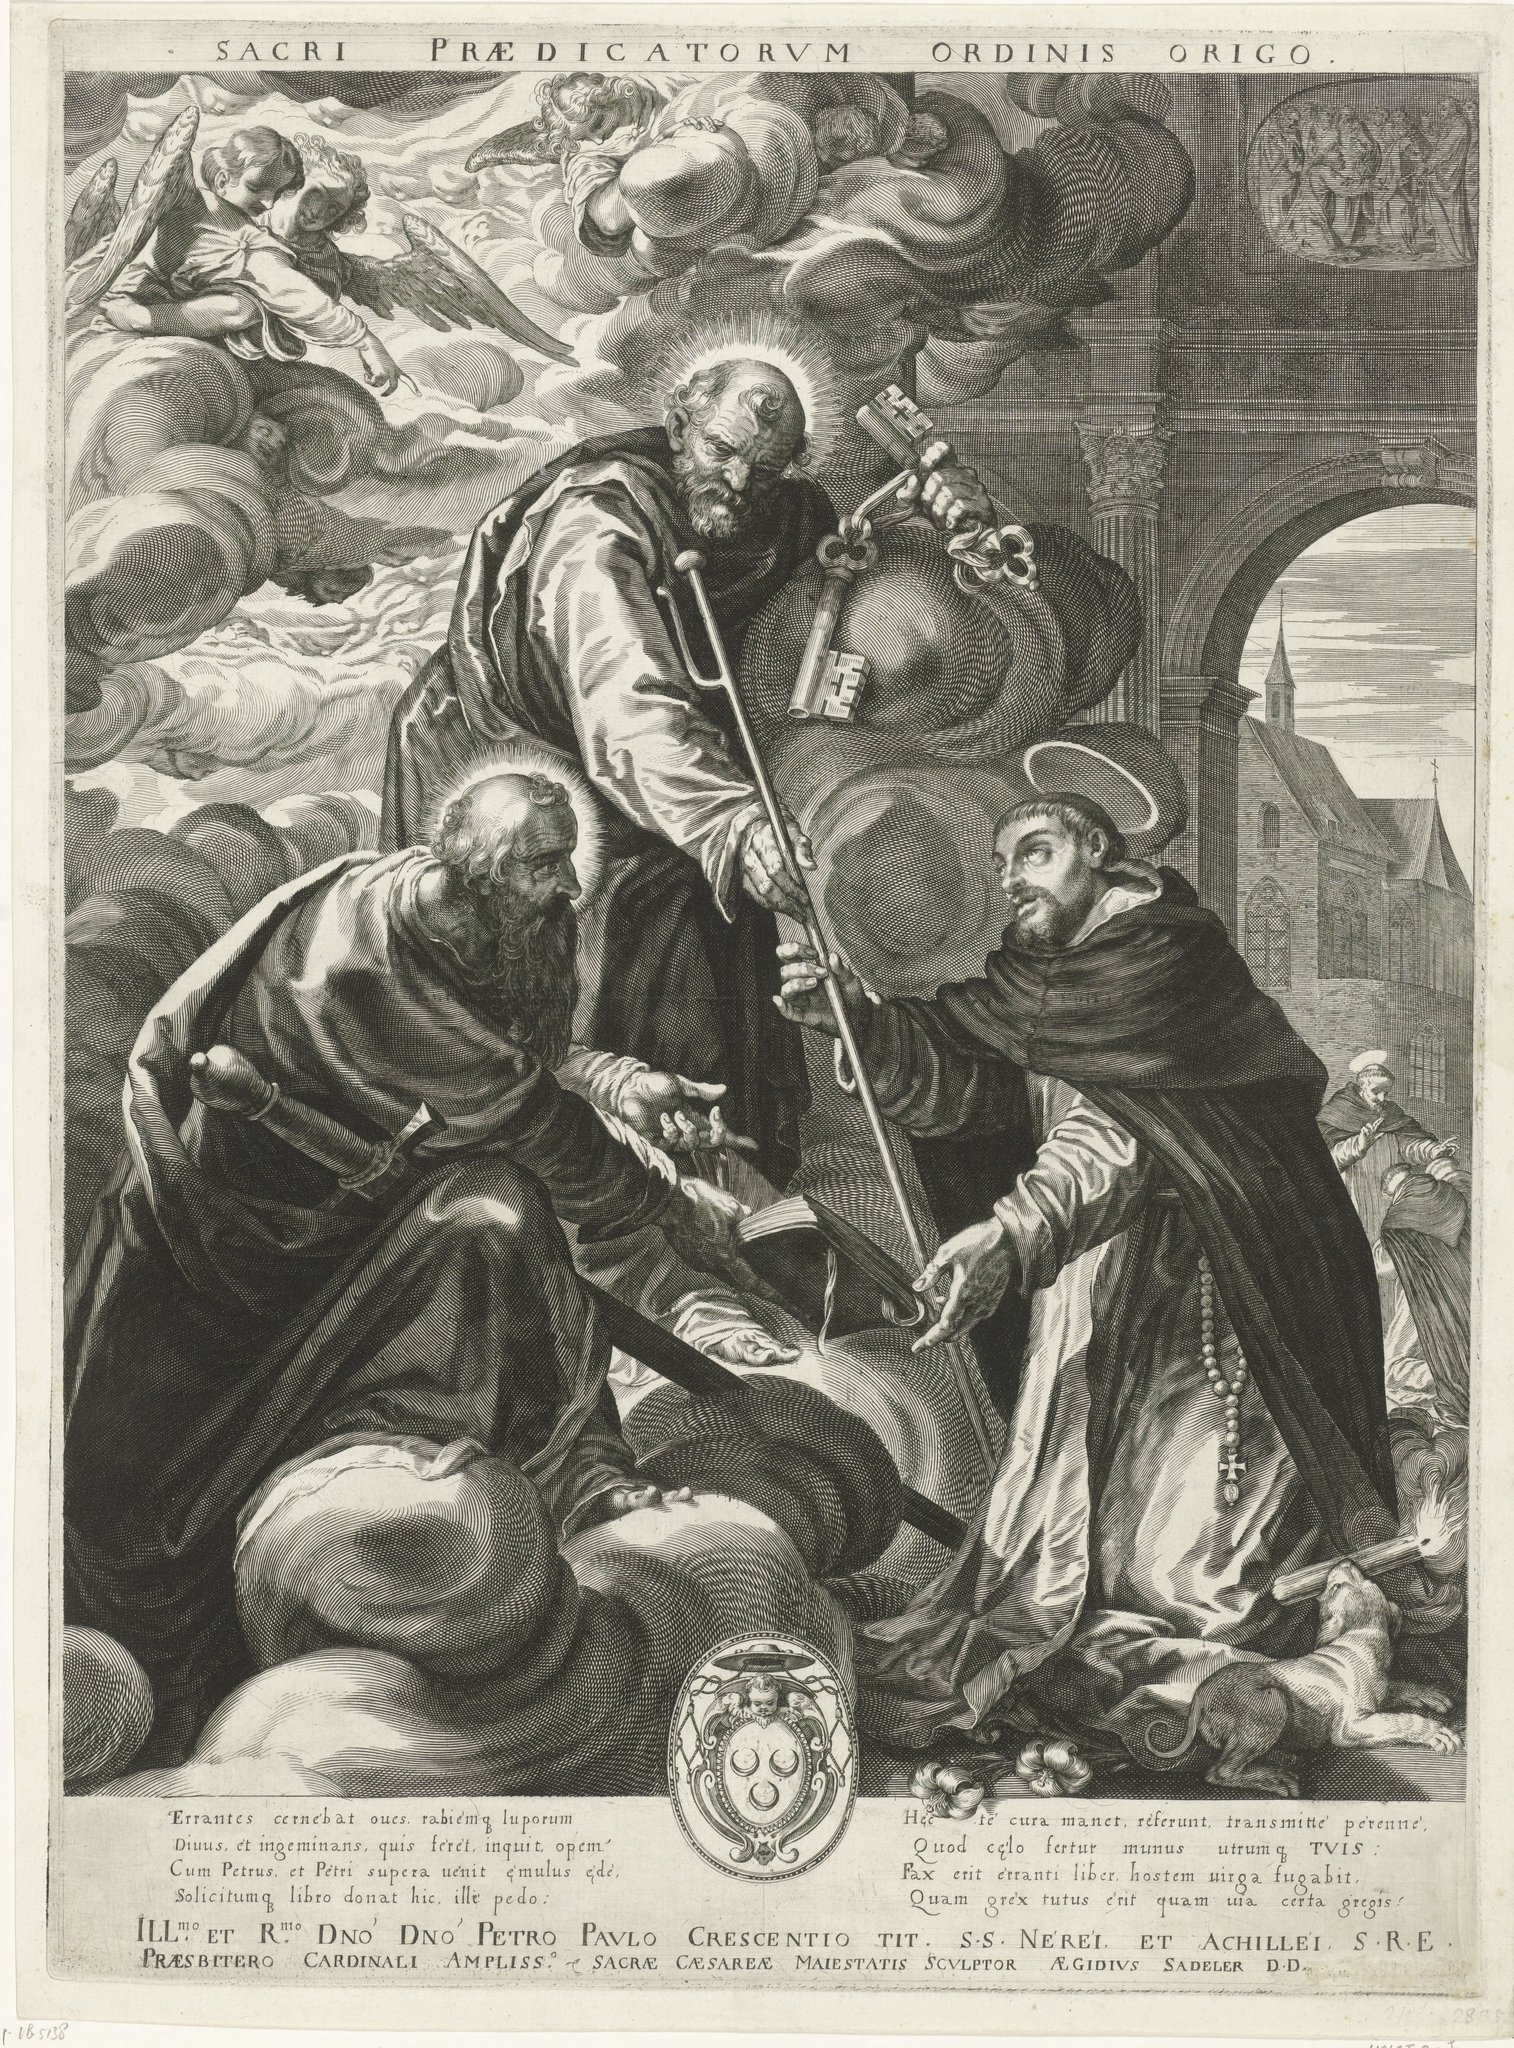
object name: print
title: Dominicus ontvangt van Petrus en Paulus opdracht om te prediken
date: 1611-1629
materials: paper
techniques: engraving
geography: prague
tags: st. dominic receives the commission to preach: st. peter and st. paul appear to him in a vision and give him a staff and a book (the gospels) (+ angel(s))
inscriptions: collector's mark: Lugt 240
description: De heilige Dominicus zit geknield op de grond, voor een stadspoort. Voor hem verschijnen Petrus en Paulus in de wolken. Ze overhandigen hem een bijbel en een wandelstaf en bevelen hem te gaan prediken. Boven hun hoofden engelen. De prent heeft een Latijns onderschrift.